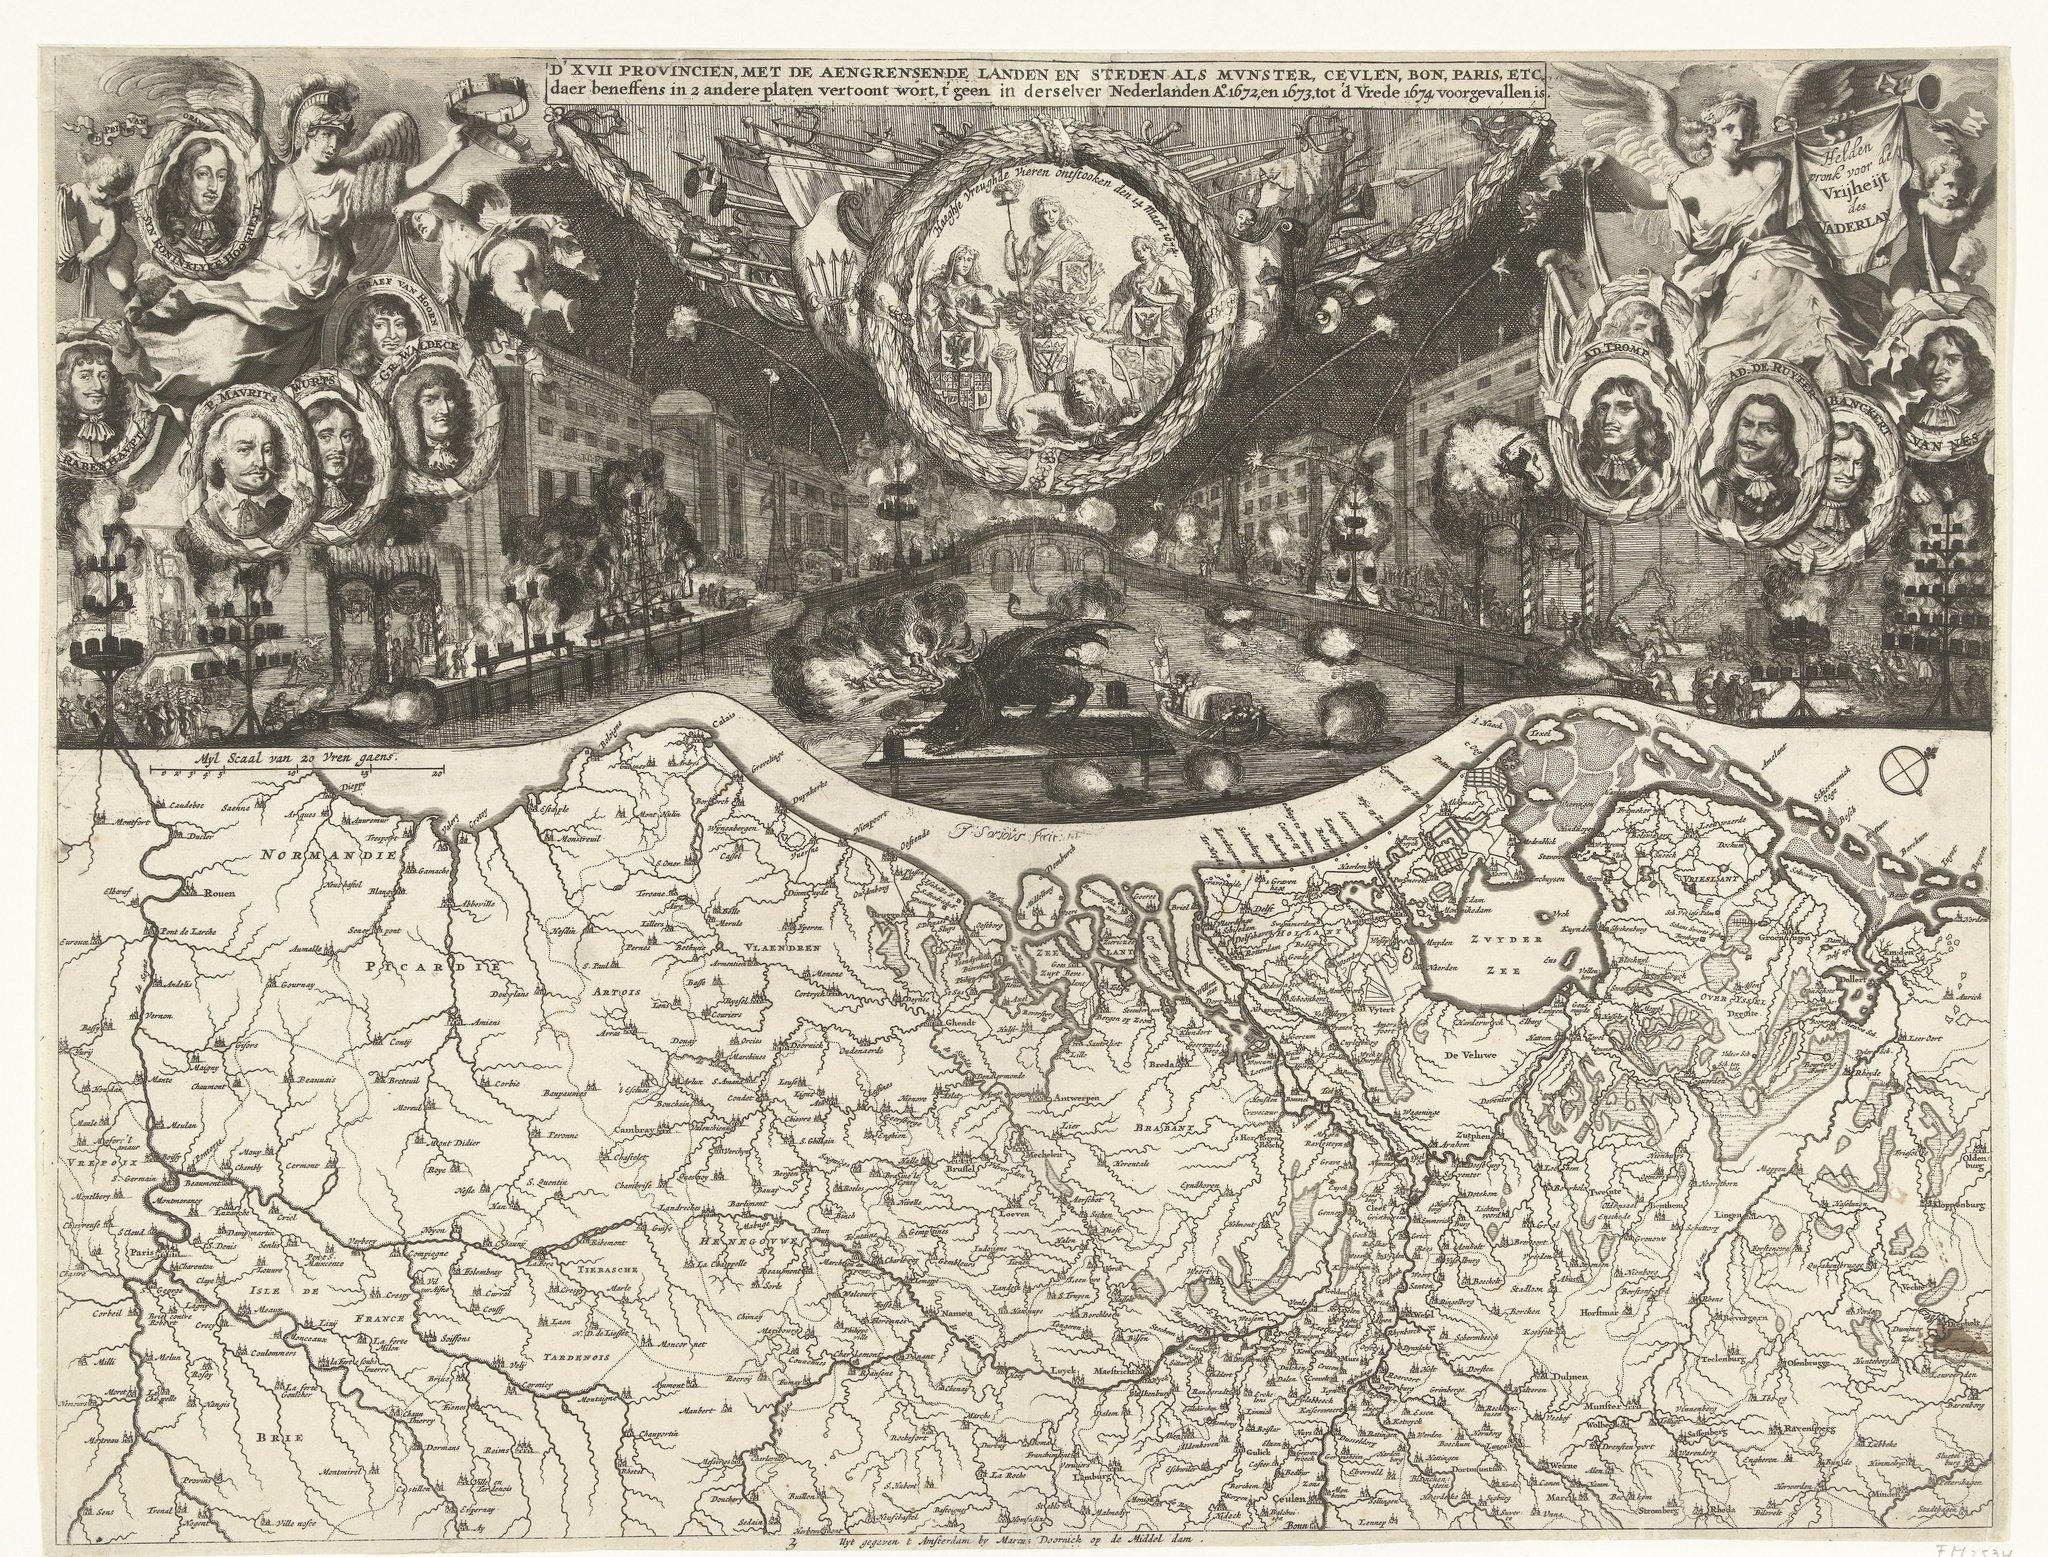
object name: print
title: Drie platen over de gebeurtenissen vanaf 1672 tot aan de vrede in 1674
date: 1674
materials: paper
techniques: engraving, etching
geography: northern netherlands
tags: flushing, michiel adriaenszoon de ruyter, rotterdam, amsterdam, cornelis tromp, earl, johan maurits graaf van nassau-siegen, the hague, william iii (prince of orange and king of england, scotland, and ireland), maps of separate countries or regions, bonfire, fire-works, festivities (+ illumination, fire-works ~ festive activities)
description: Vreugdevuren te afgestoklen te Den Haag bij de viering van de Vrede van Westminster op 19 februari 1674. Op de gracht wordt het vuurwerk in een draak op een gracht afgestoken. Daarboven in een lauwerkrans de Vrede, de Hollandse Leeuw en twee provinciemaagden. Links en rechts de Overwinning en de Faam met medaillons met portretten van de belangrijkste personen. Onderaan een kaart van de Nederlanden en Noord-Frankrijk. Genummerd onderaan: 2.